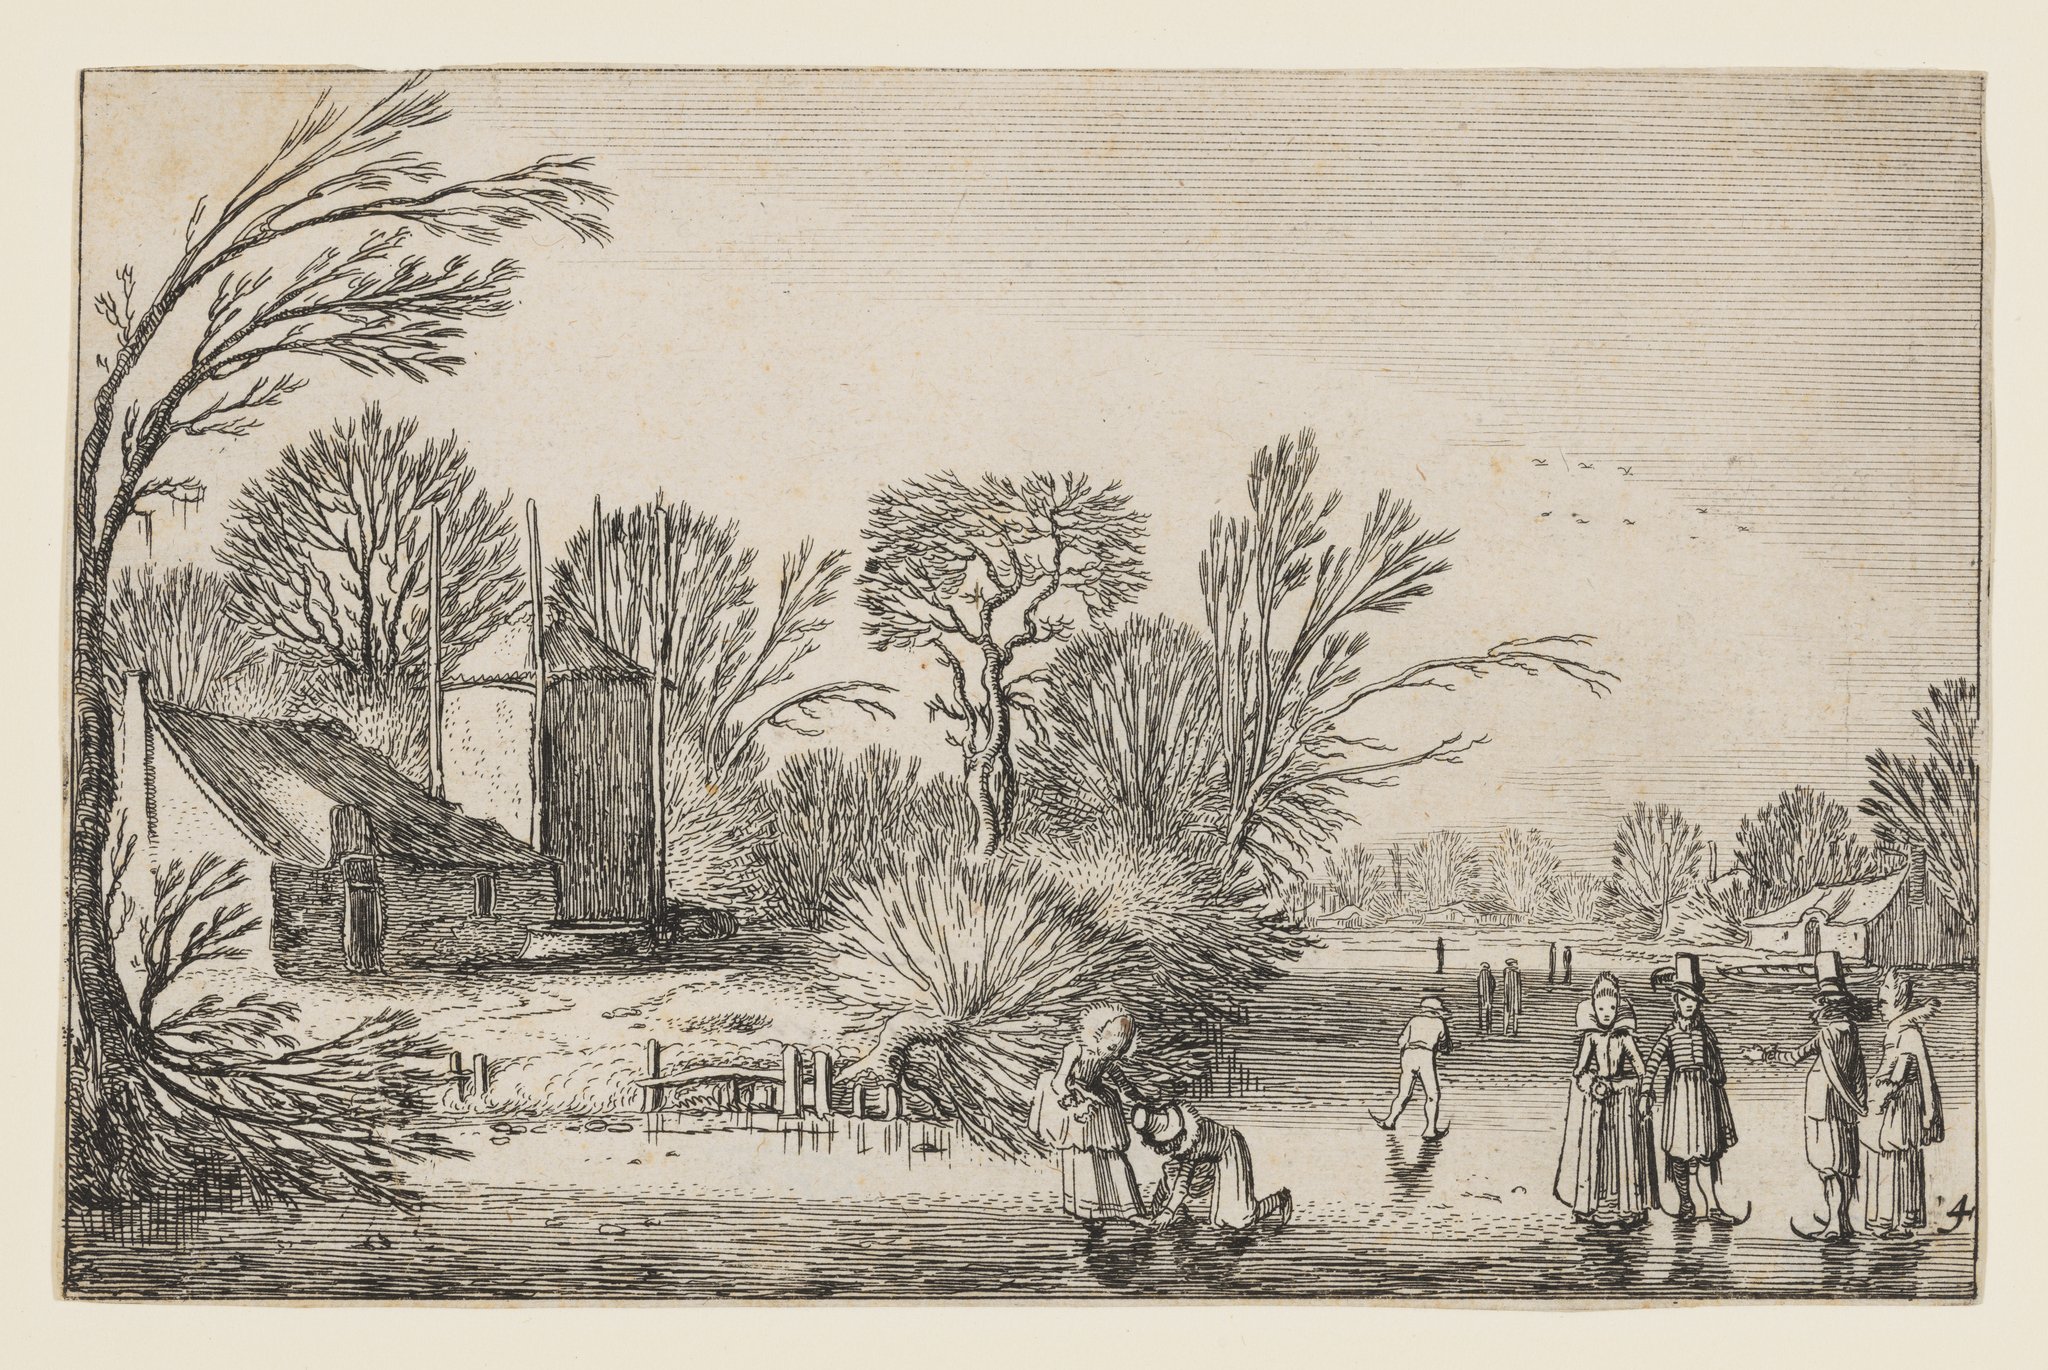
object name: print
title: Winter Landscape with Skaters, from a series of 60 landscapes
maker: jan van de velde (i)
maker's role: artist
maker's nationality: netherlandish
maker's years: 1568-1623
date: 1616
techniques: etching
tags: skating,winter